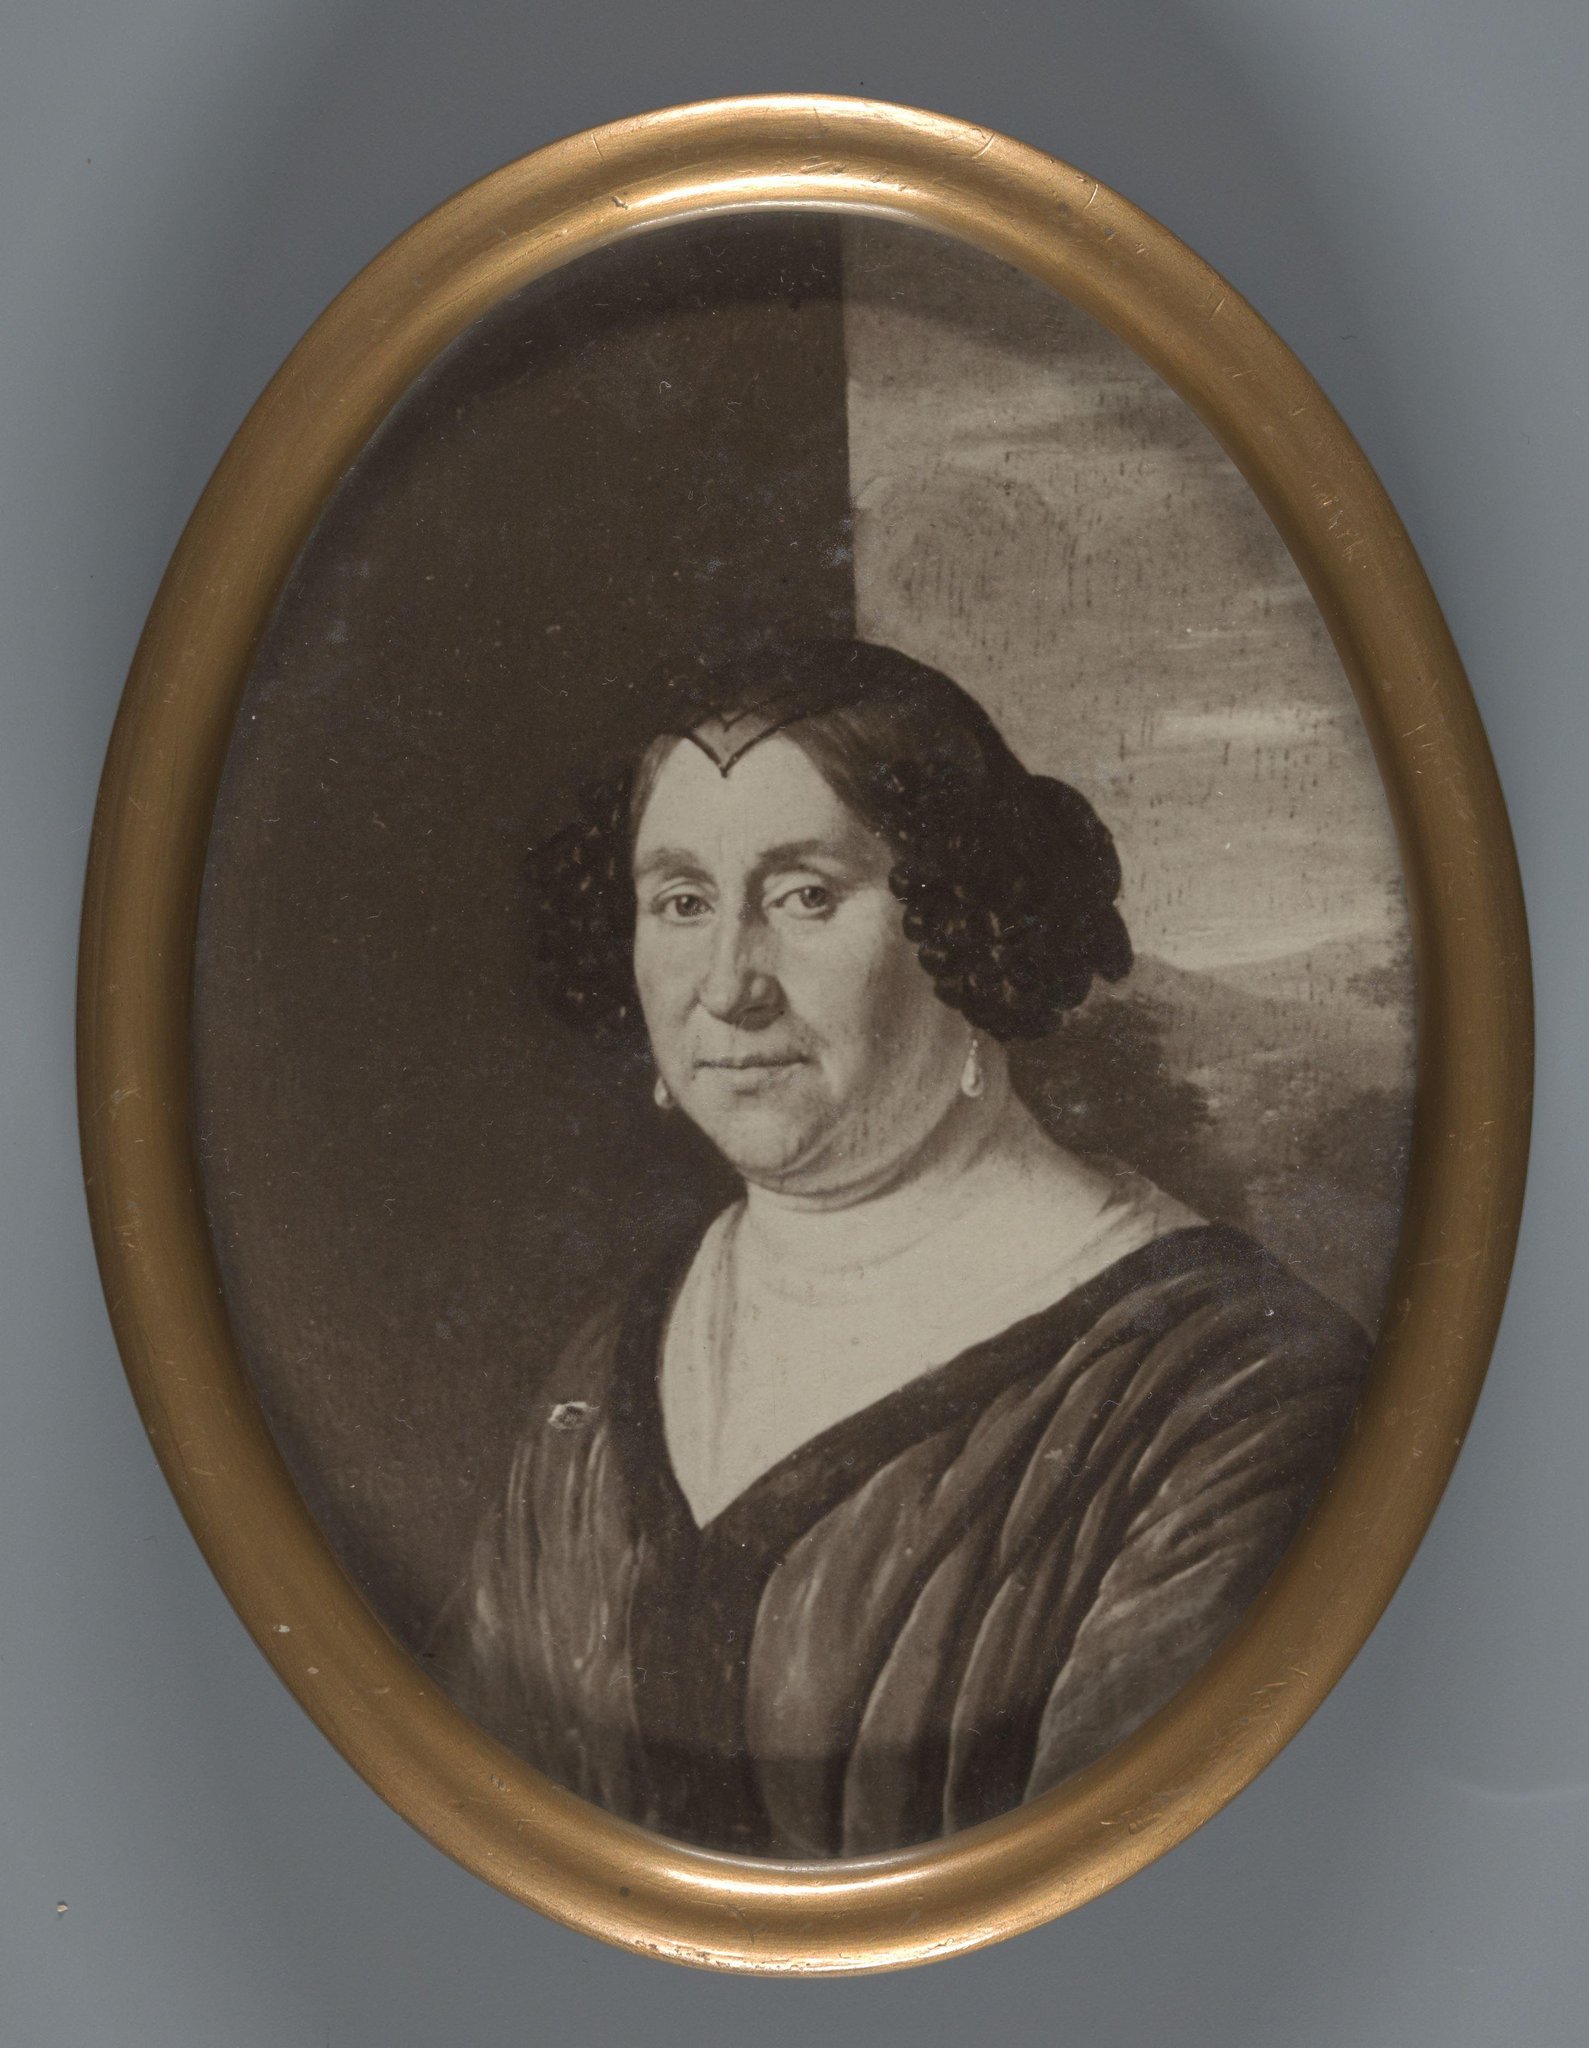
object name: frame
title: Fotoreproductie van een geschilderd portret van Petronella van Duyren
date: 1890-1920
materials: paper, cardboard, glass, metal, wood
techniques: gelatin silver print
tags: historical persons - bb - woman, picture, painting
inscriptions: inscription: ‘Petronella van Duren/ Echtgen: van Ds. G. Kolff (...) 1712/ 2’